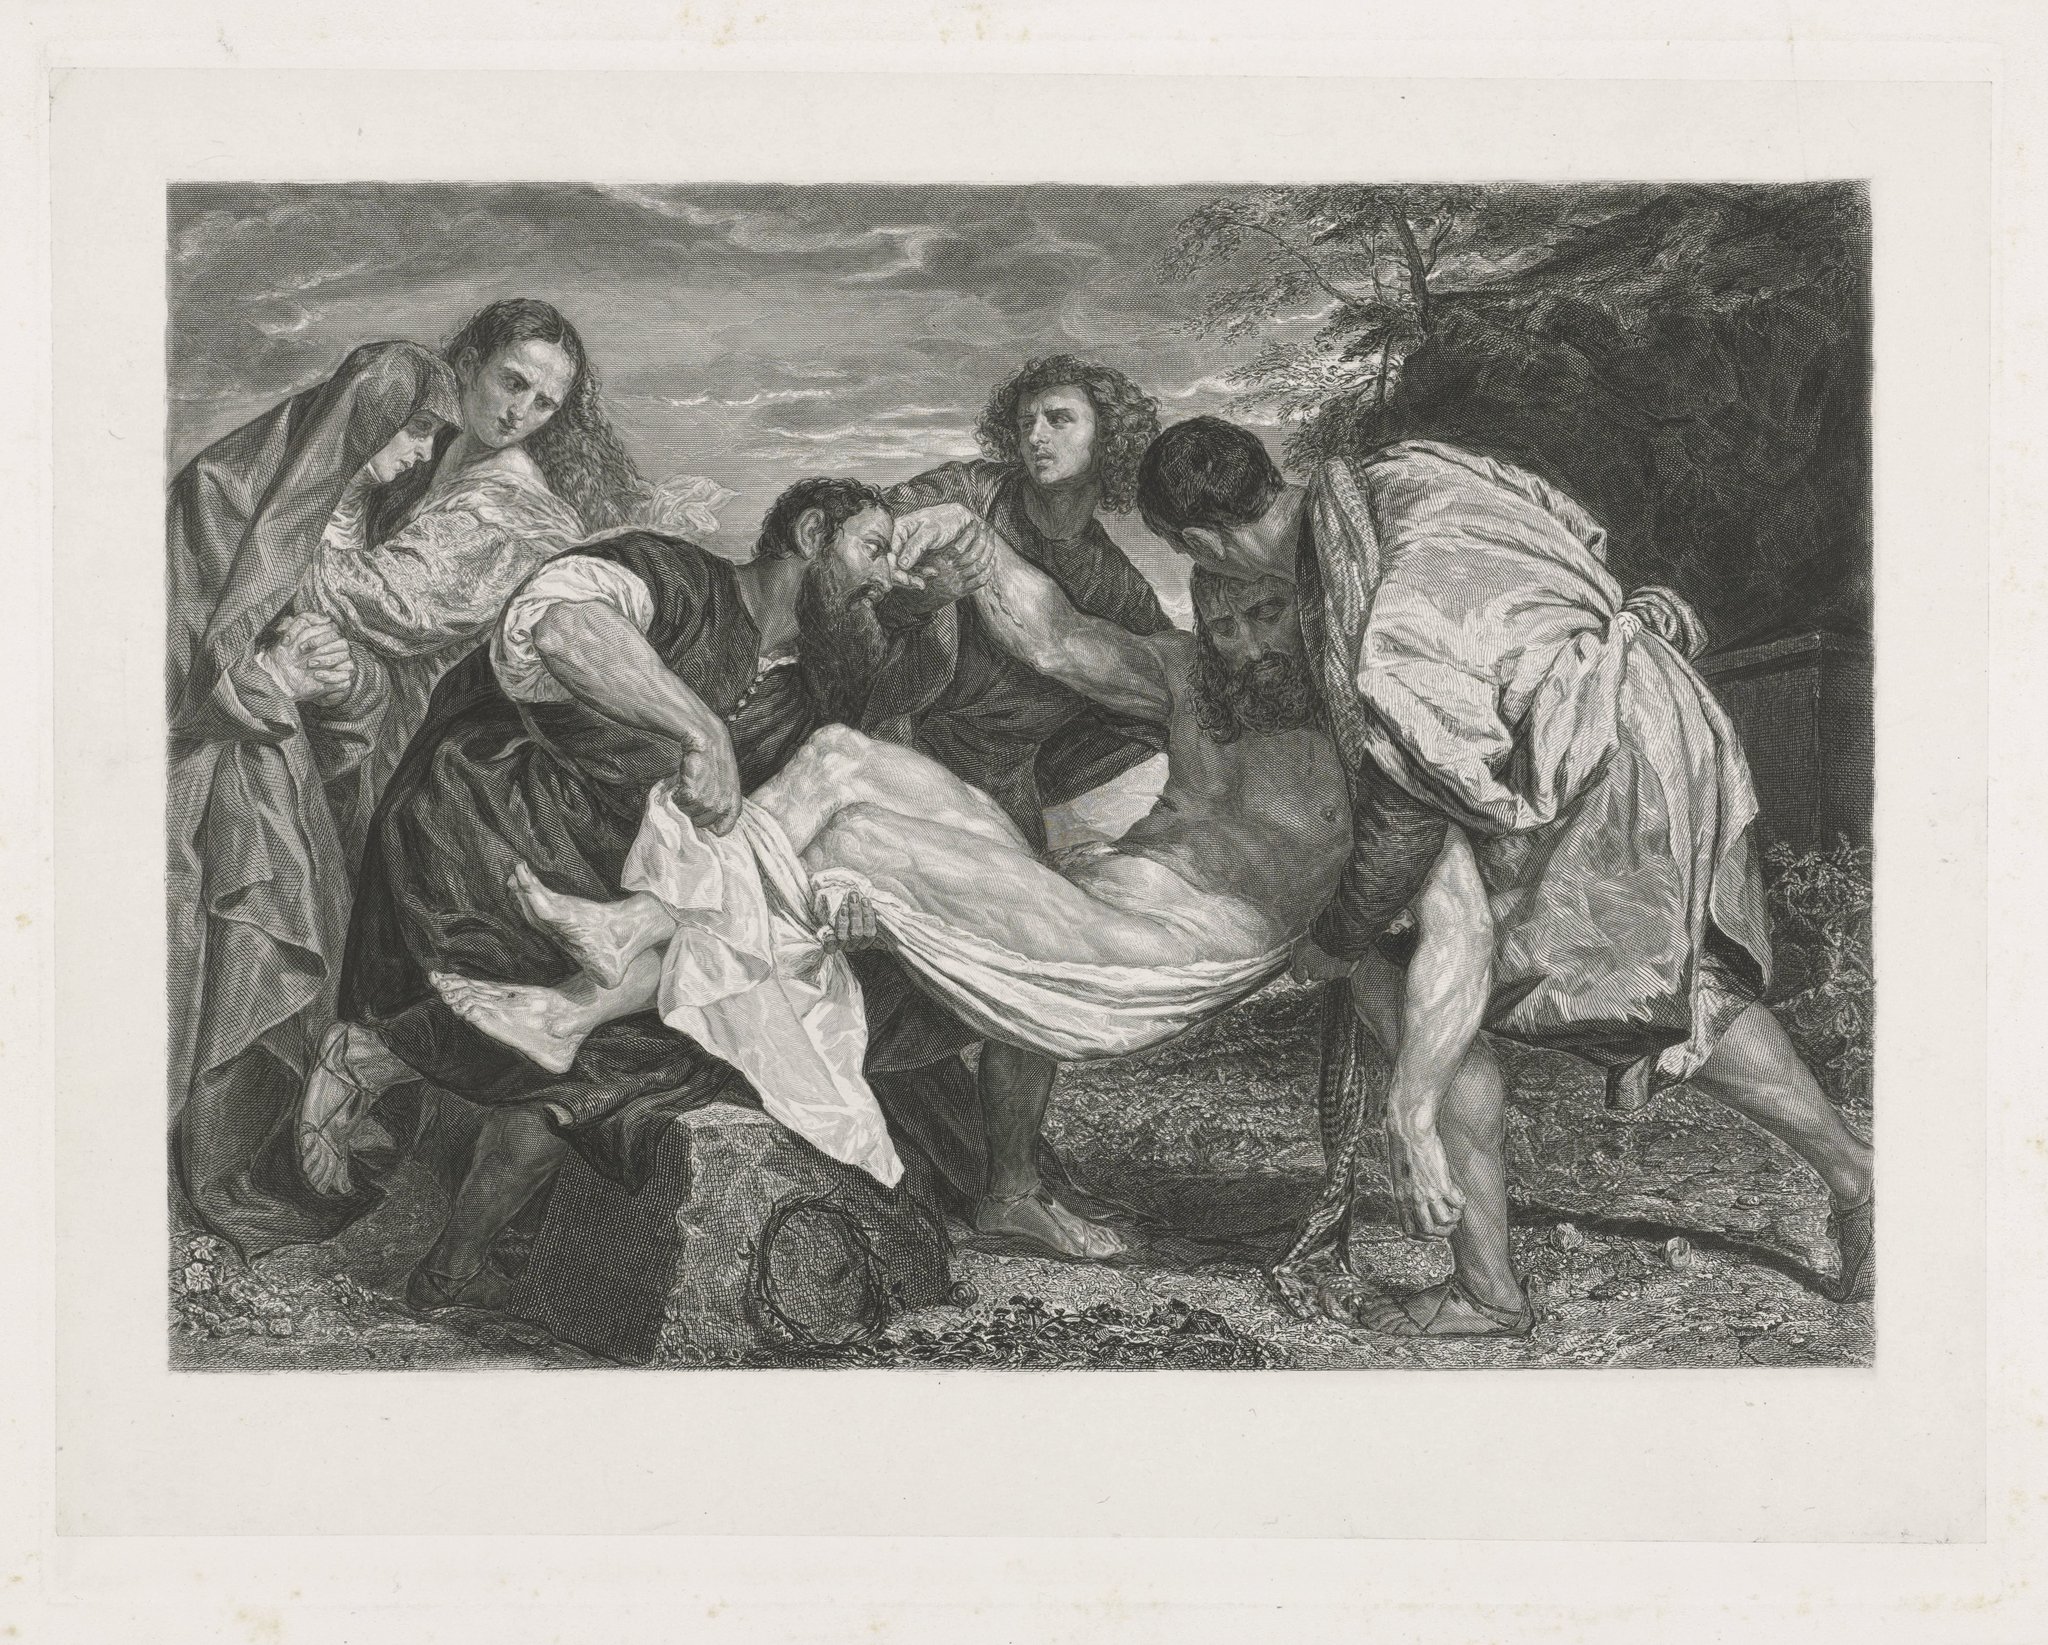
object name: print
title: Graflegging van Christus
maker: johannes de mare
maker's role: draughtsman, print maker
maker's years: 1806-1889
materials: paper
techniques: engraving, etching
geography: paris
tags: christ's entombment (possibly by angels)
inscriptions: collector's mark: Lugt 2228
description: De graflegging van Christus. Het lichaam van Christus wordt naar het graf gedragen door Jozef van Aritmathea, Nicodemus en een derde discipel. Johannes ondersteunt de Maria.